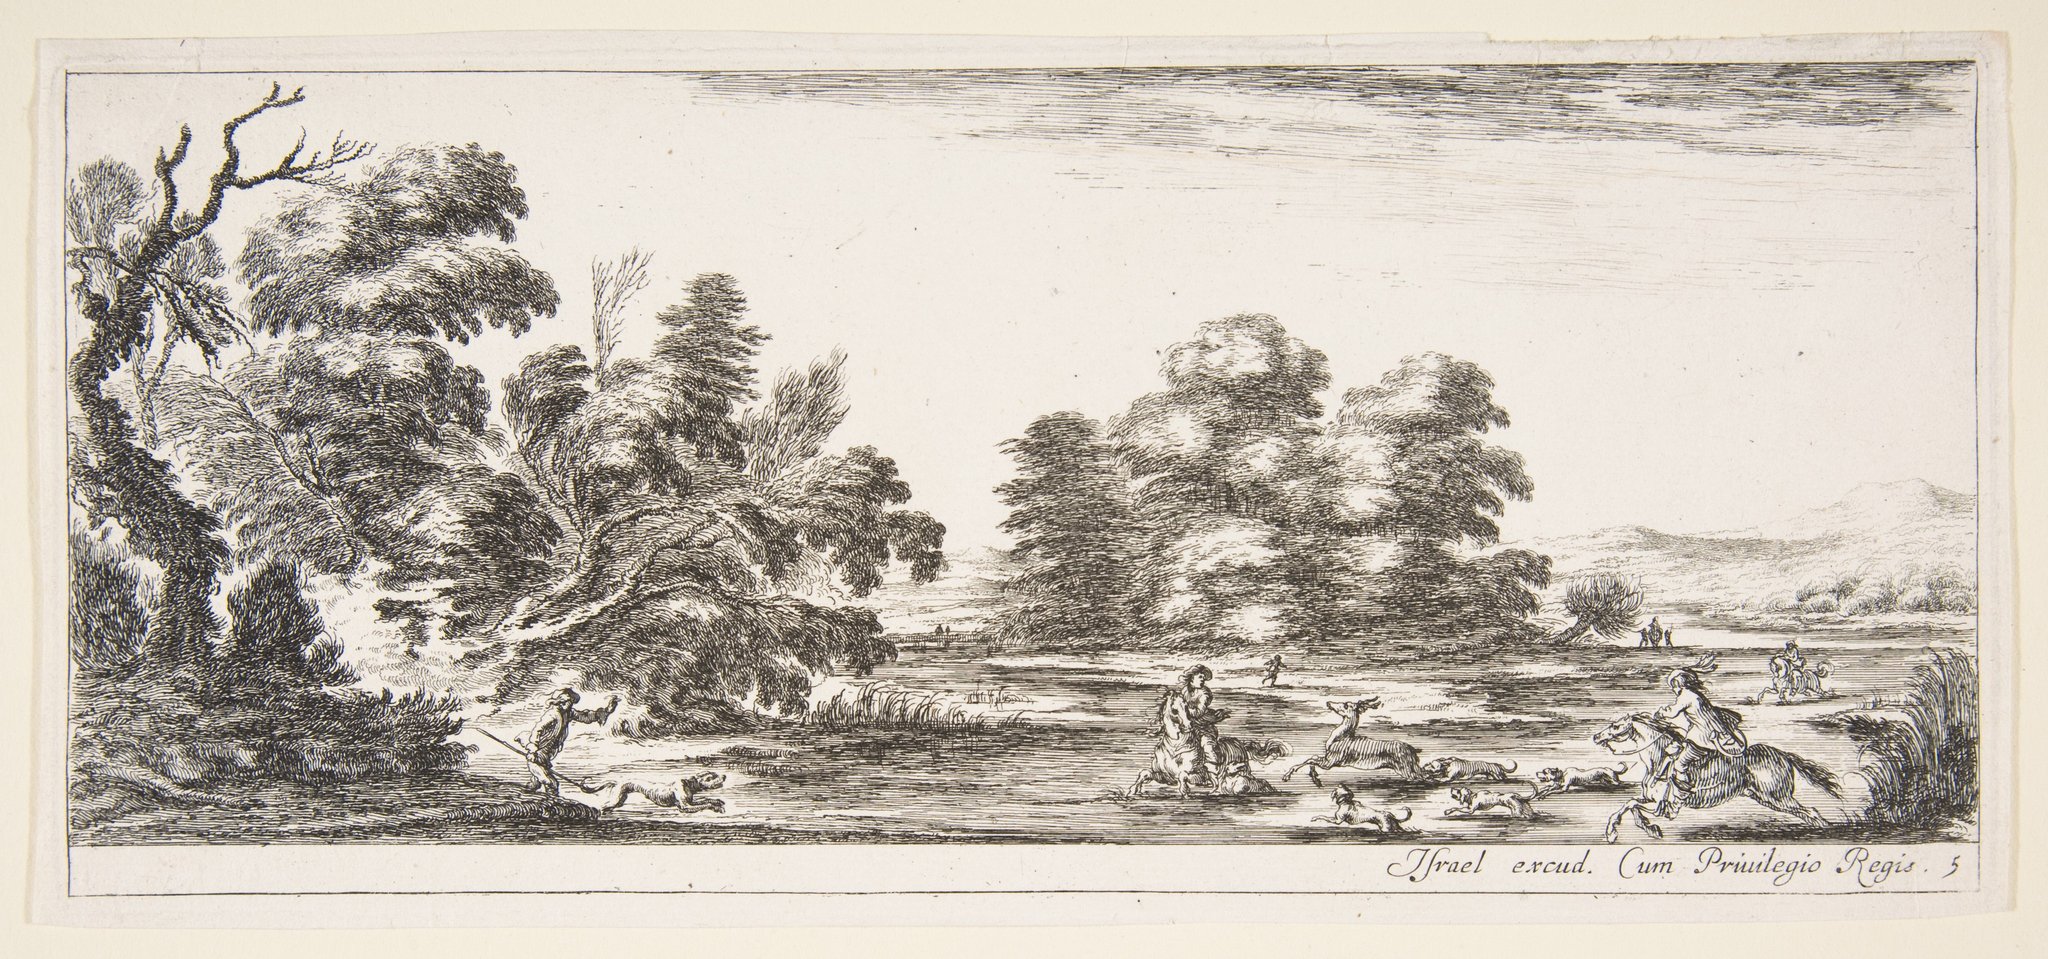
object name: print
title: Plate 5: two horsemen in a stream to right, riding towards the left, following four dogs chasing a stag, another dog running into the water from the left, from 'Various landscapes' (Divers paysages)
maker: stefano della bella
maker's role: artist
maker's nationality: italian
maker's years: 1610-1664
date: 1641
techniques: etching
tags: hunting,deer,dogs,horses